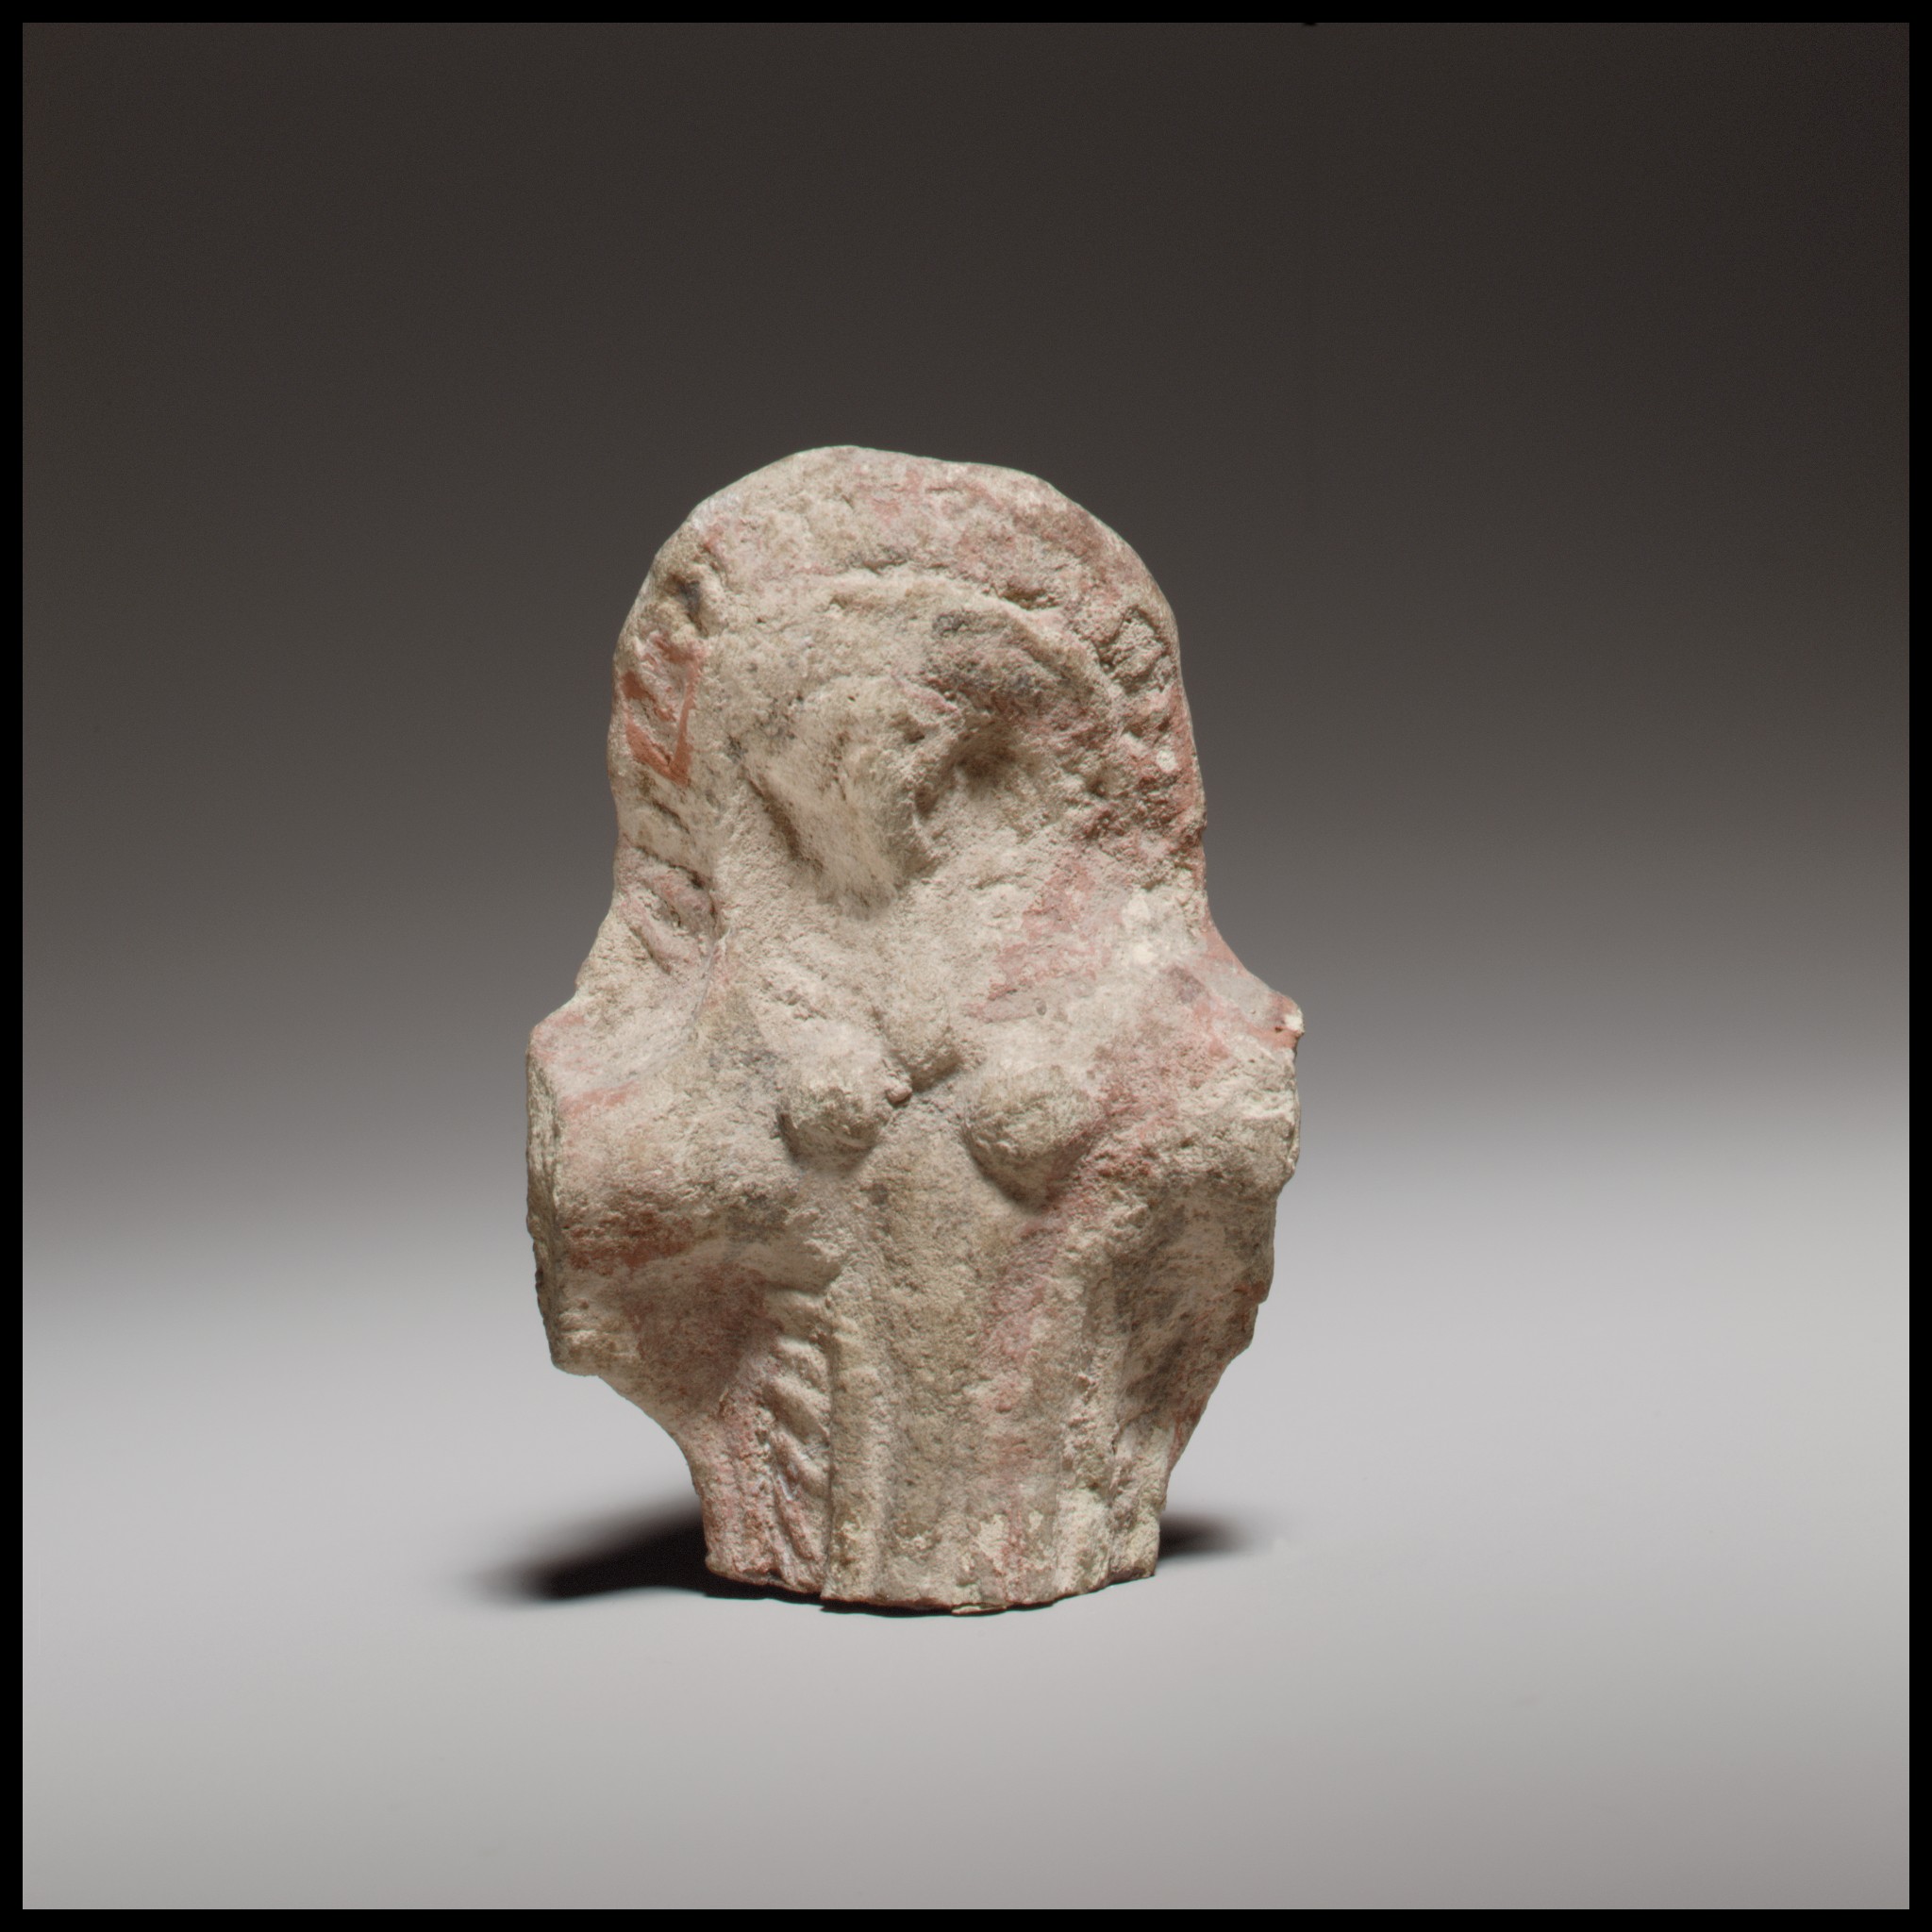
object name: statuette of a flute player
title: Standing female figurine (cruciform)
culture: cypriot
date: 400-301 BCE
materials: terracotta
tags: women